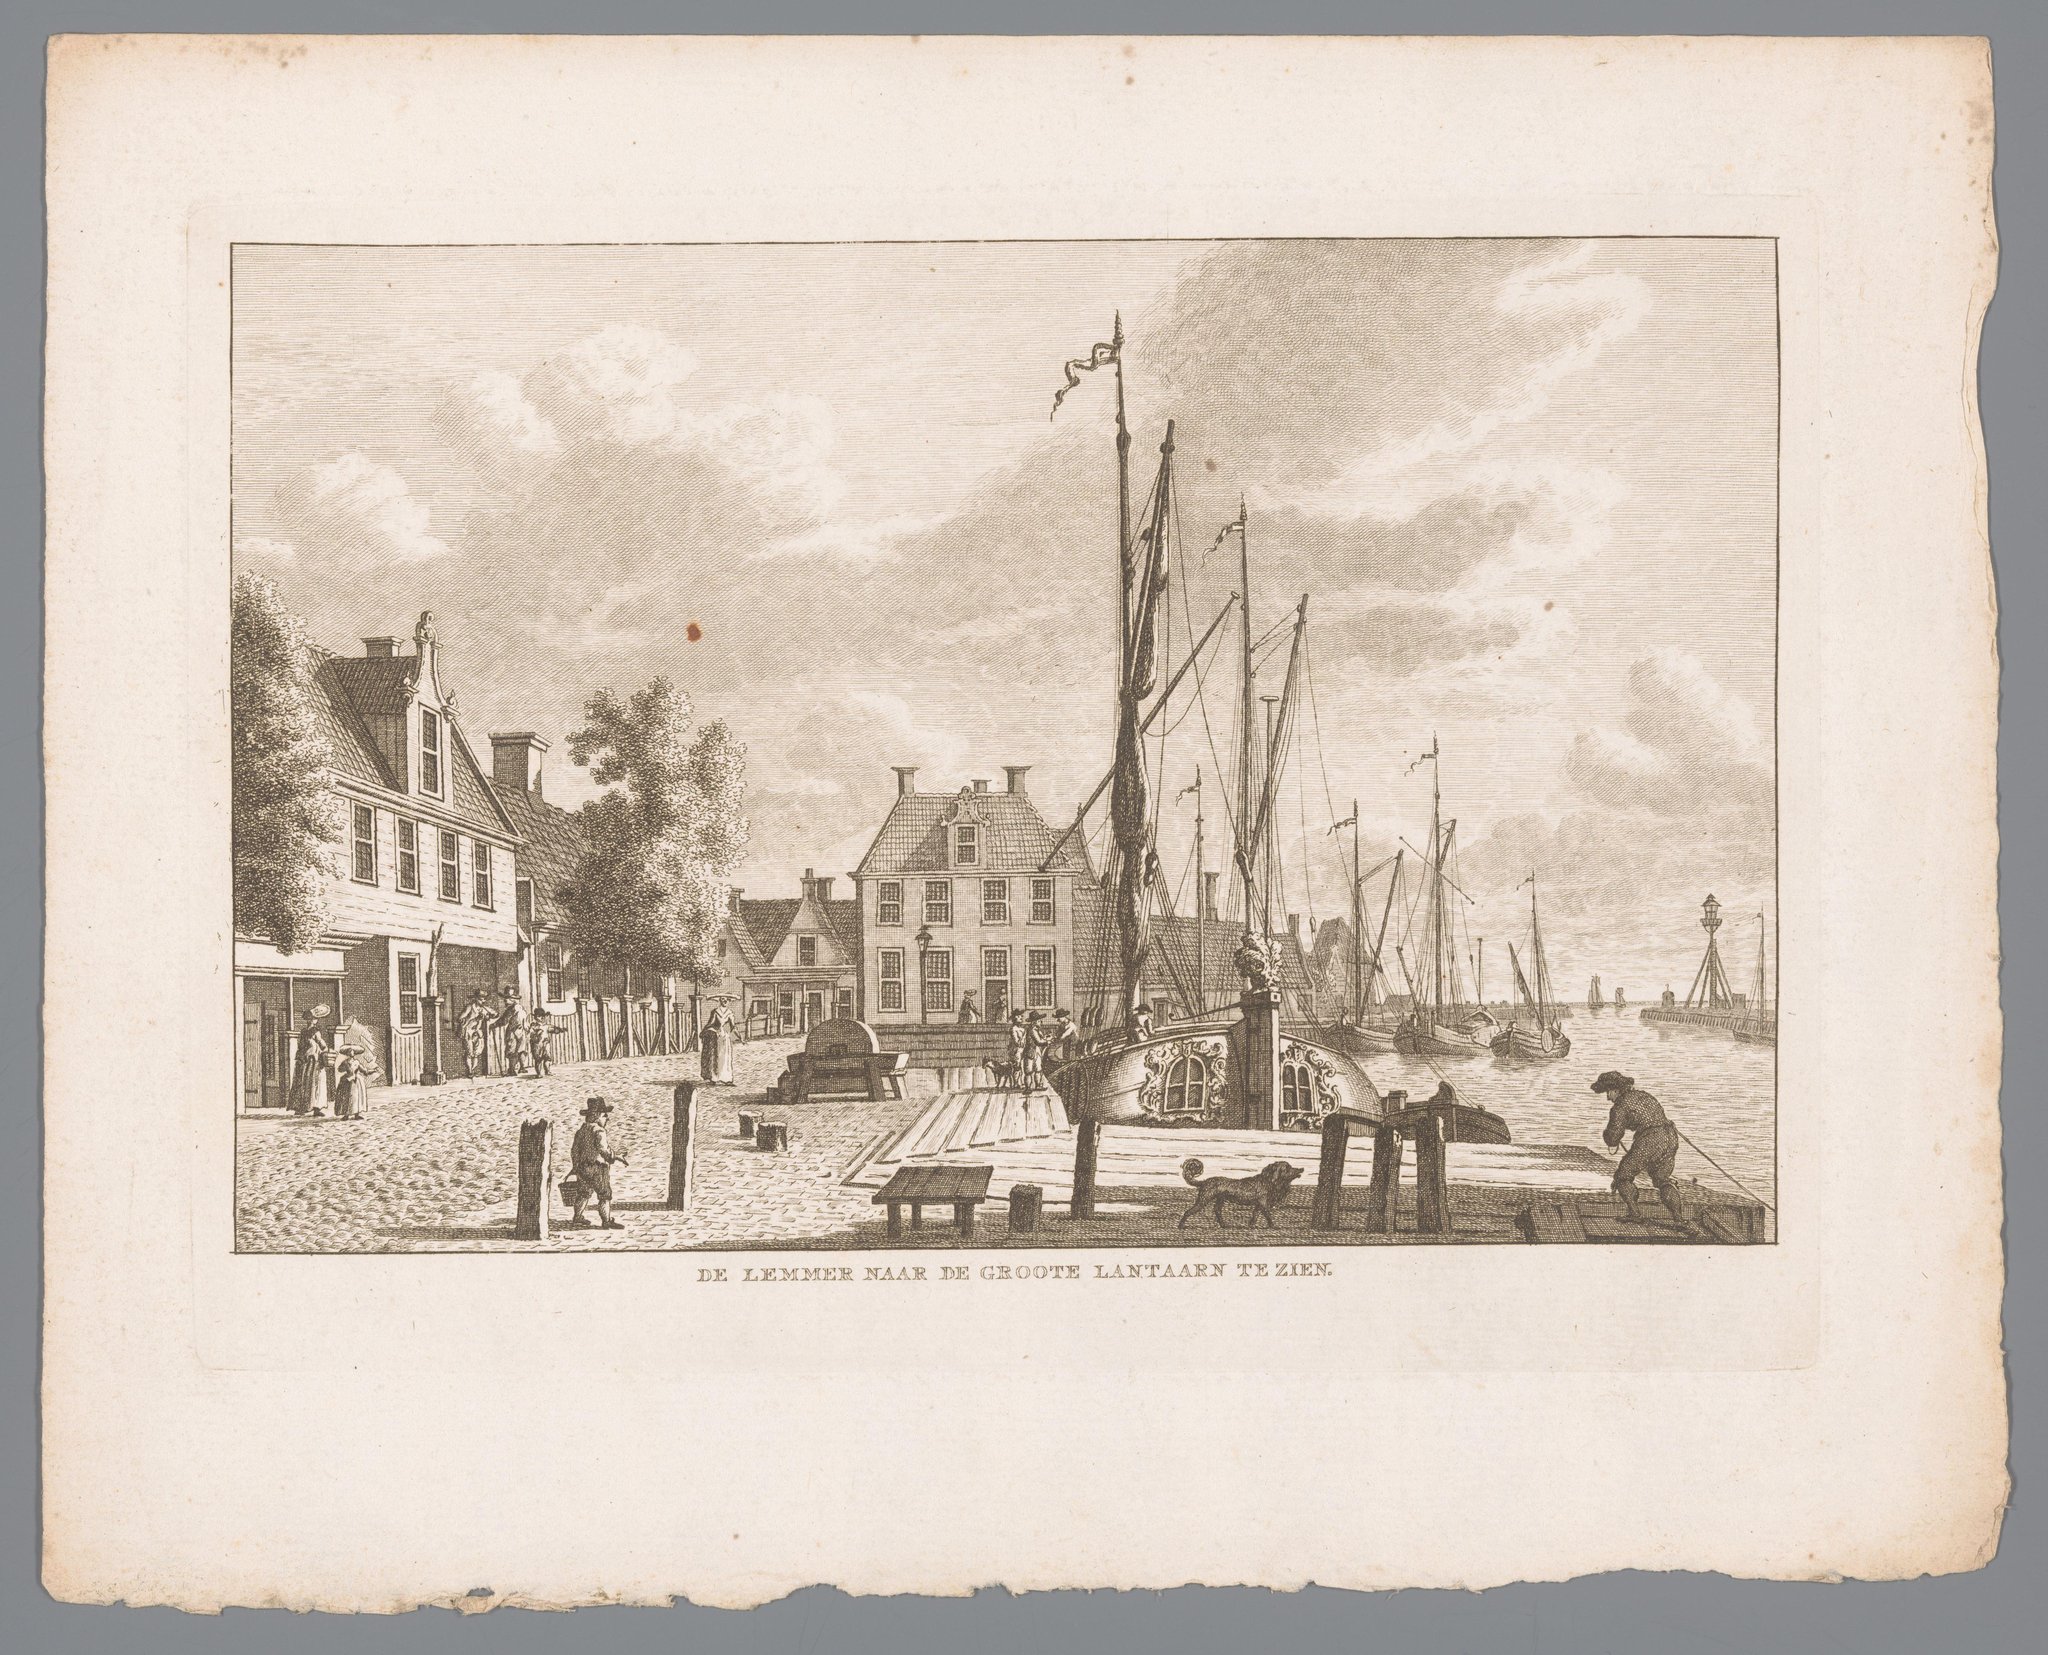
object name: print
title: Haven van Lemmer met gezicht op 'de grote lantaarn'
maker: carel frederik bendorp (i)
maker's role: print maker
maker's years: 1736-1814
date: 1786-1792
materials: paper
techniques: etching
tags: harbour, city-view in general; 'veduta'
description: Prent uit: Vaderlandsche gezichten, of afbeeldingen van den tegenwoordigen staat der Vereenigde Nederlanden (…). Amsterdam: Hendrik Gartman, Willem Vermandel en Jan Willem Smit, 1786-1792. Uitgegeven in afleveringen met ieder een eigen bifolium en inhoudsopgave. Alle prenten in deze publicatie zijn gegraveerd door Carel Frederik Bendorp (I) en, in de meeste gevallen, gebaseerd op tekeningen van Jan Bulthuis.